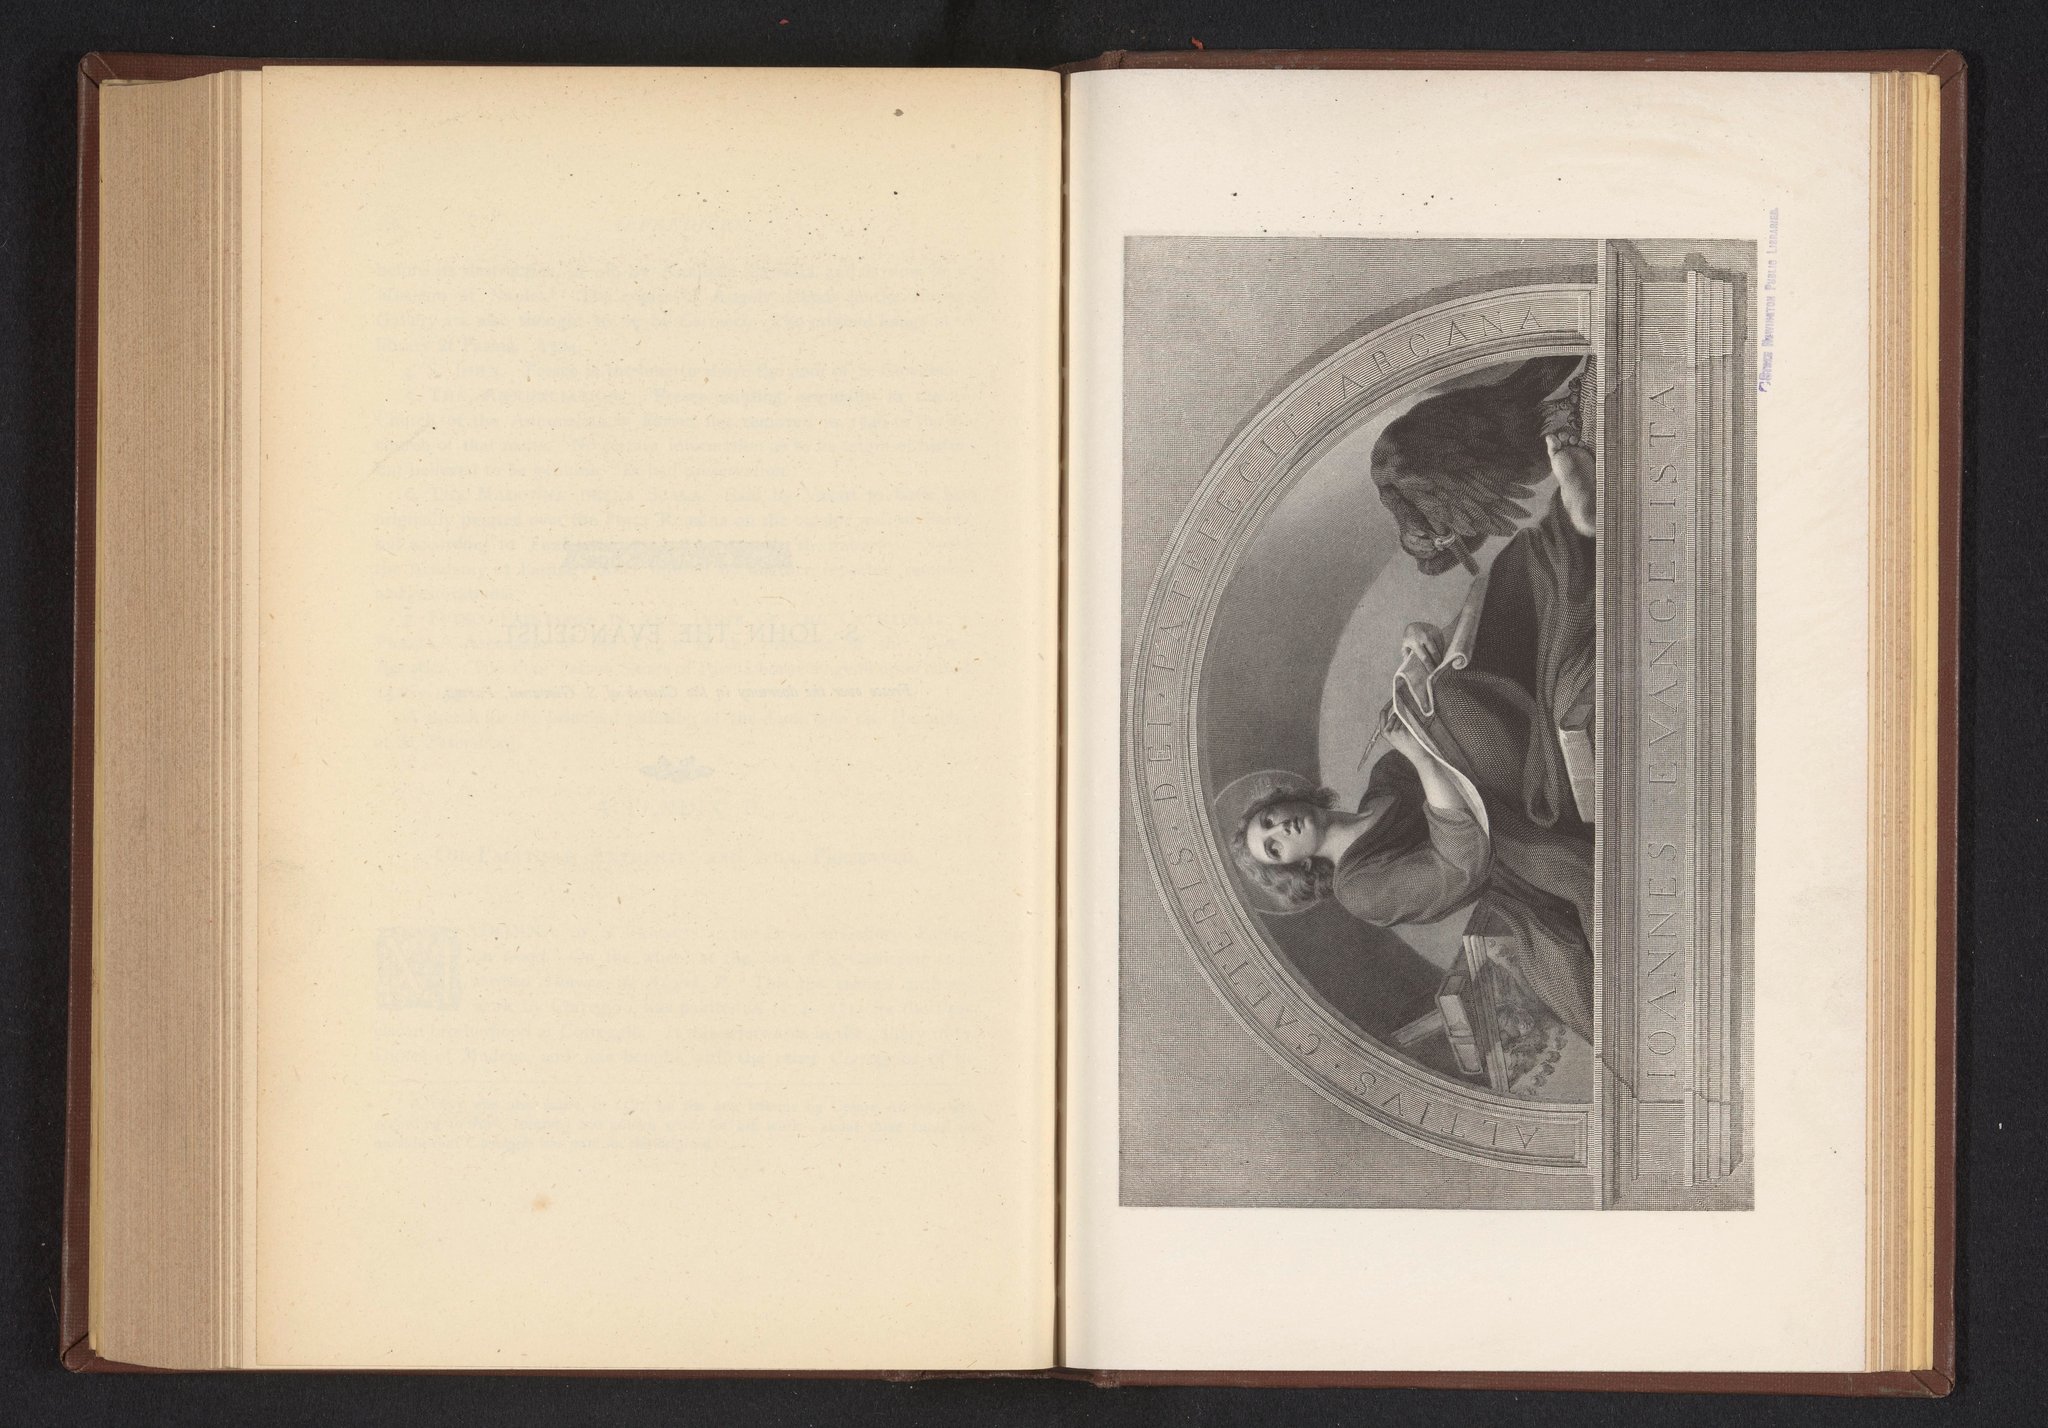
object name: page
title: Fotoreproductie van een prent naar een fresco, voorstellende Johannes de evangelist met een adelaar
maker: Anonymous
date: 1870-1876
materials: paper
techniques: photograph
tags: st. john the evangelist writing the gospel, usually the eagle present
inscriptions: inscription: ‘Stoke Newington Public Libraries’